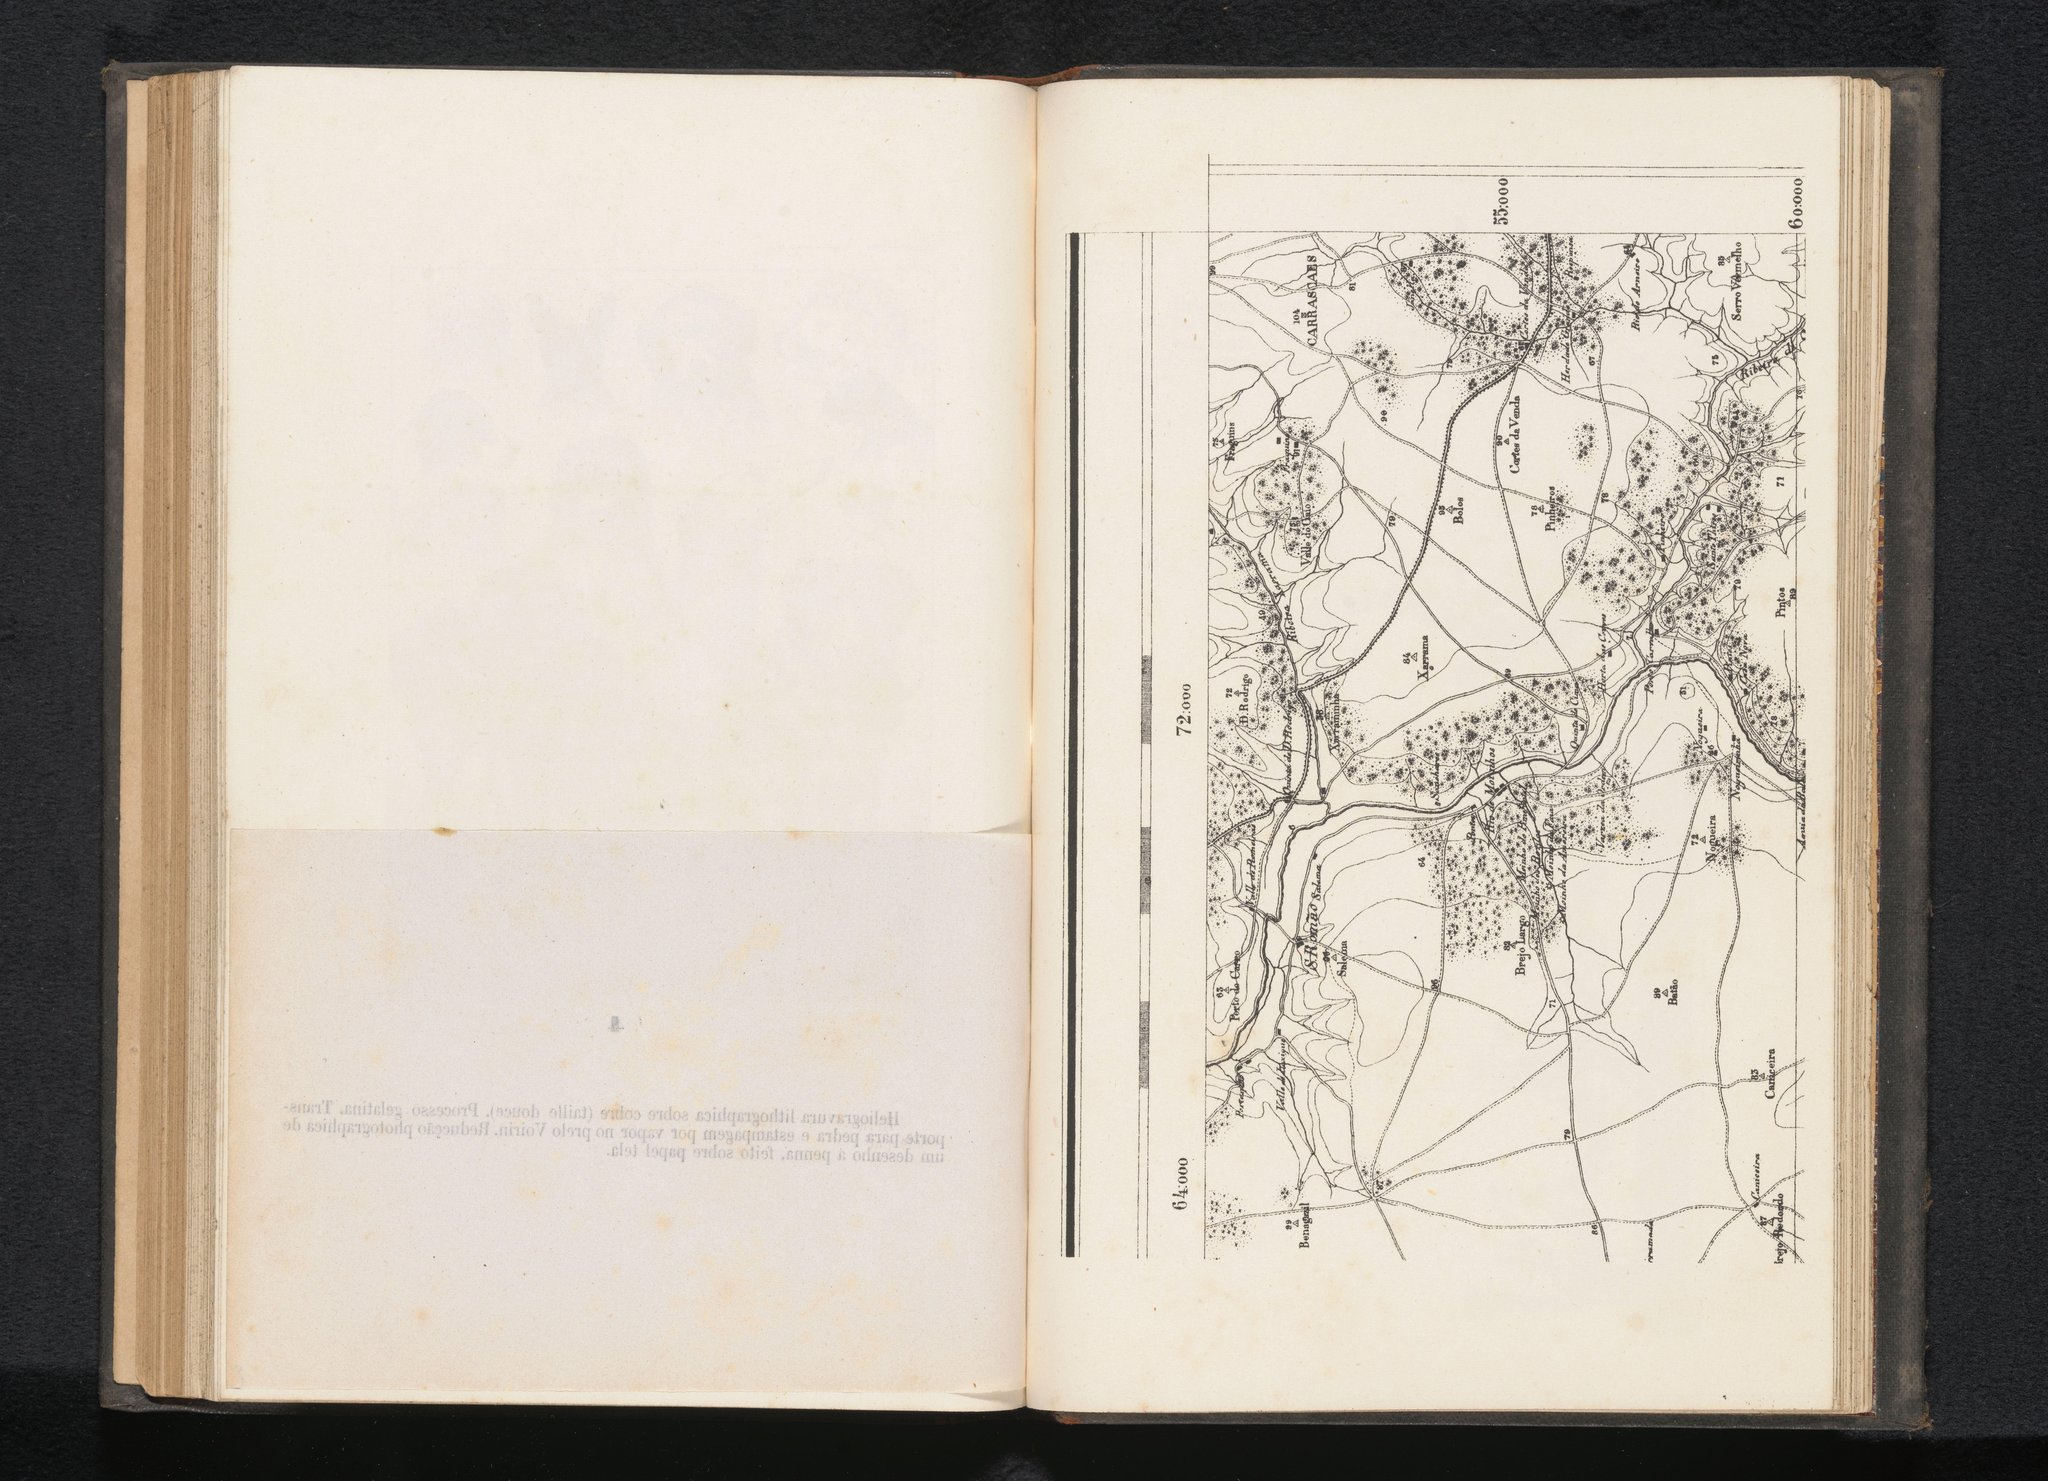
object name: photomechanical print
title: Fotoreproductie van een kaart van een gebied in Portugal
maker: Anonymous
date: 1866-1876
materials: paper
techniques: photoaquatint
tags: maps, atlases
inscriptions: number: ‘4’